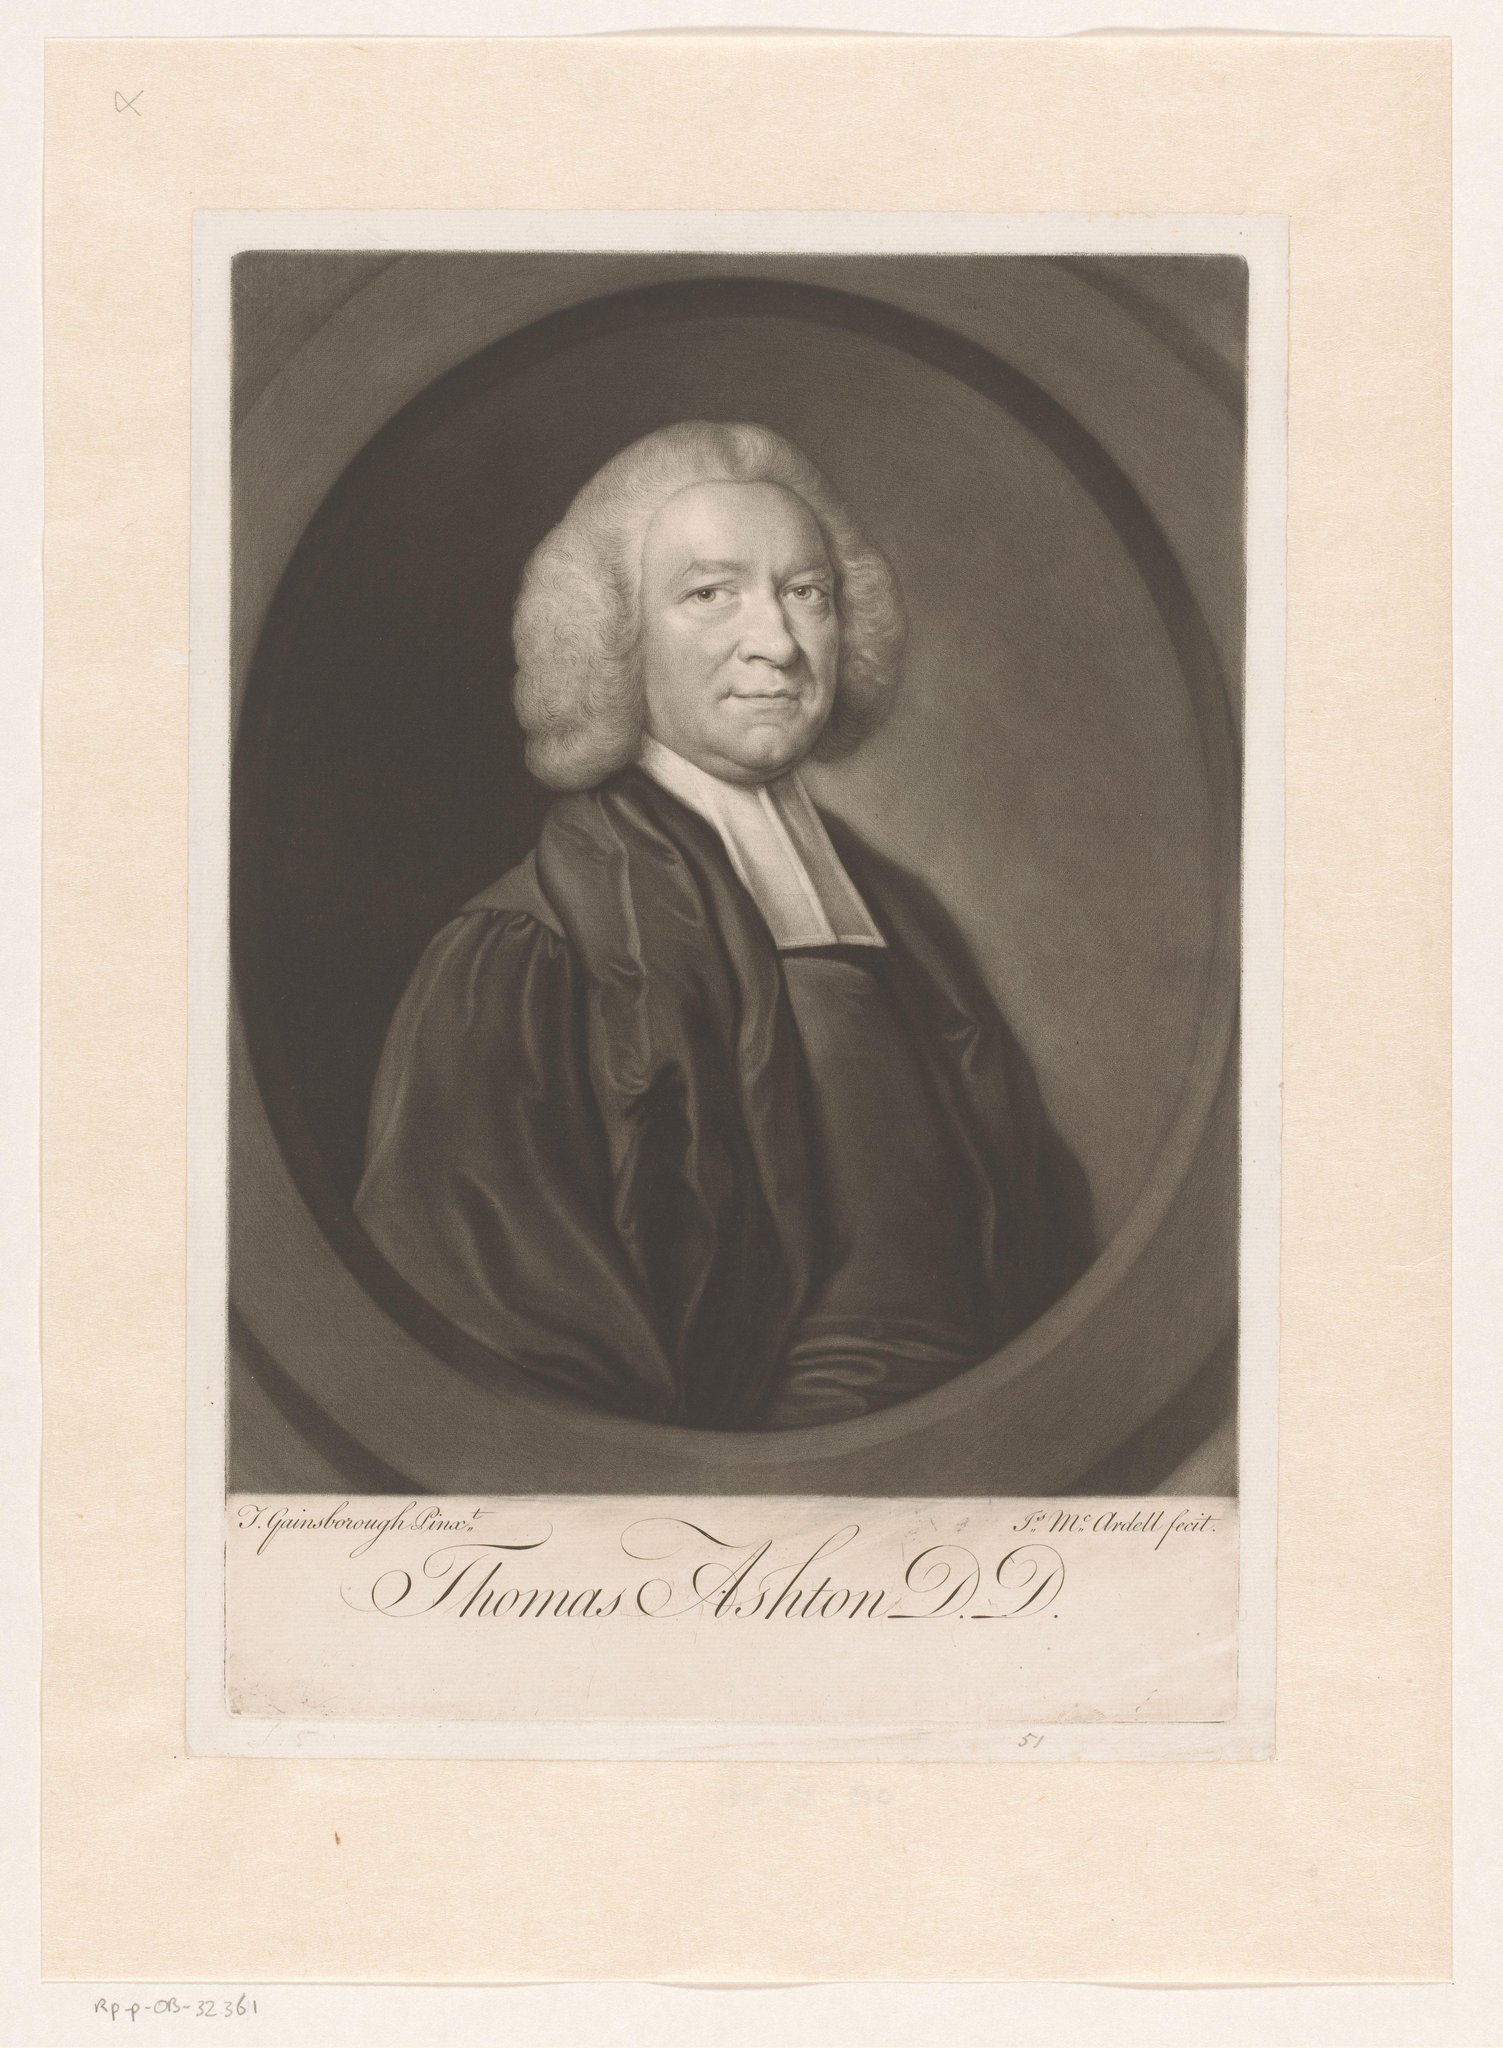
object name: print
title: Thomas Ashton D.D.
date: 1750-1765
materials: paper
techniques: mezzotint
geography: london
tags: historical persons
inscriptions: collector's mark: Lugt 240